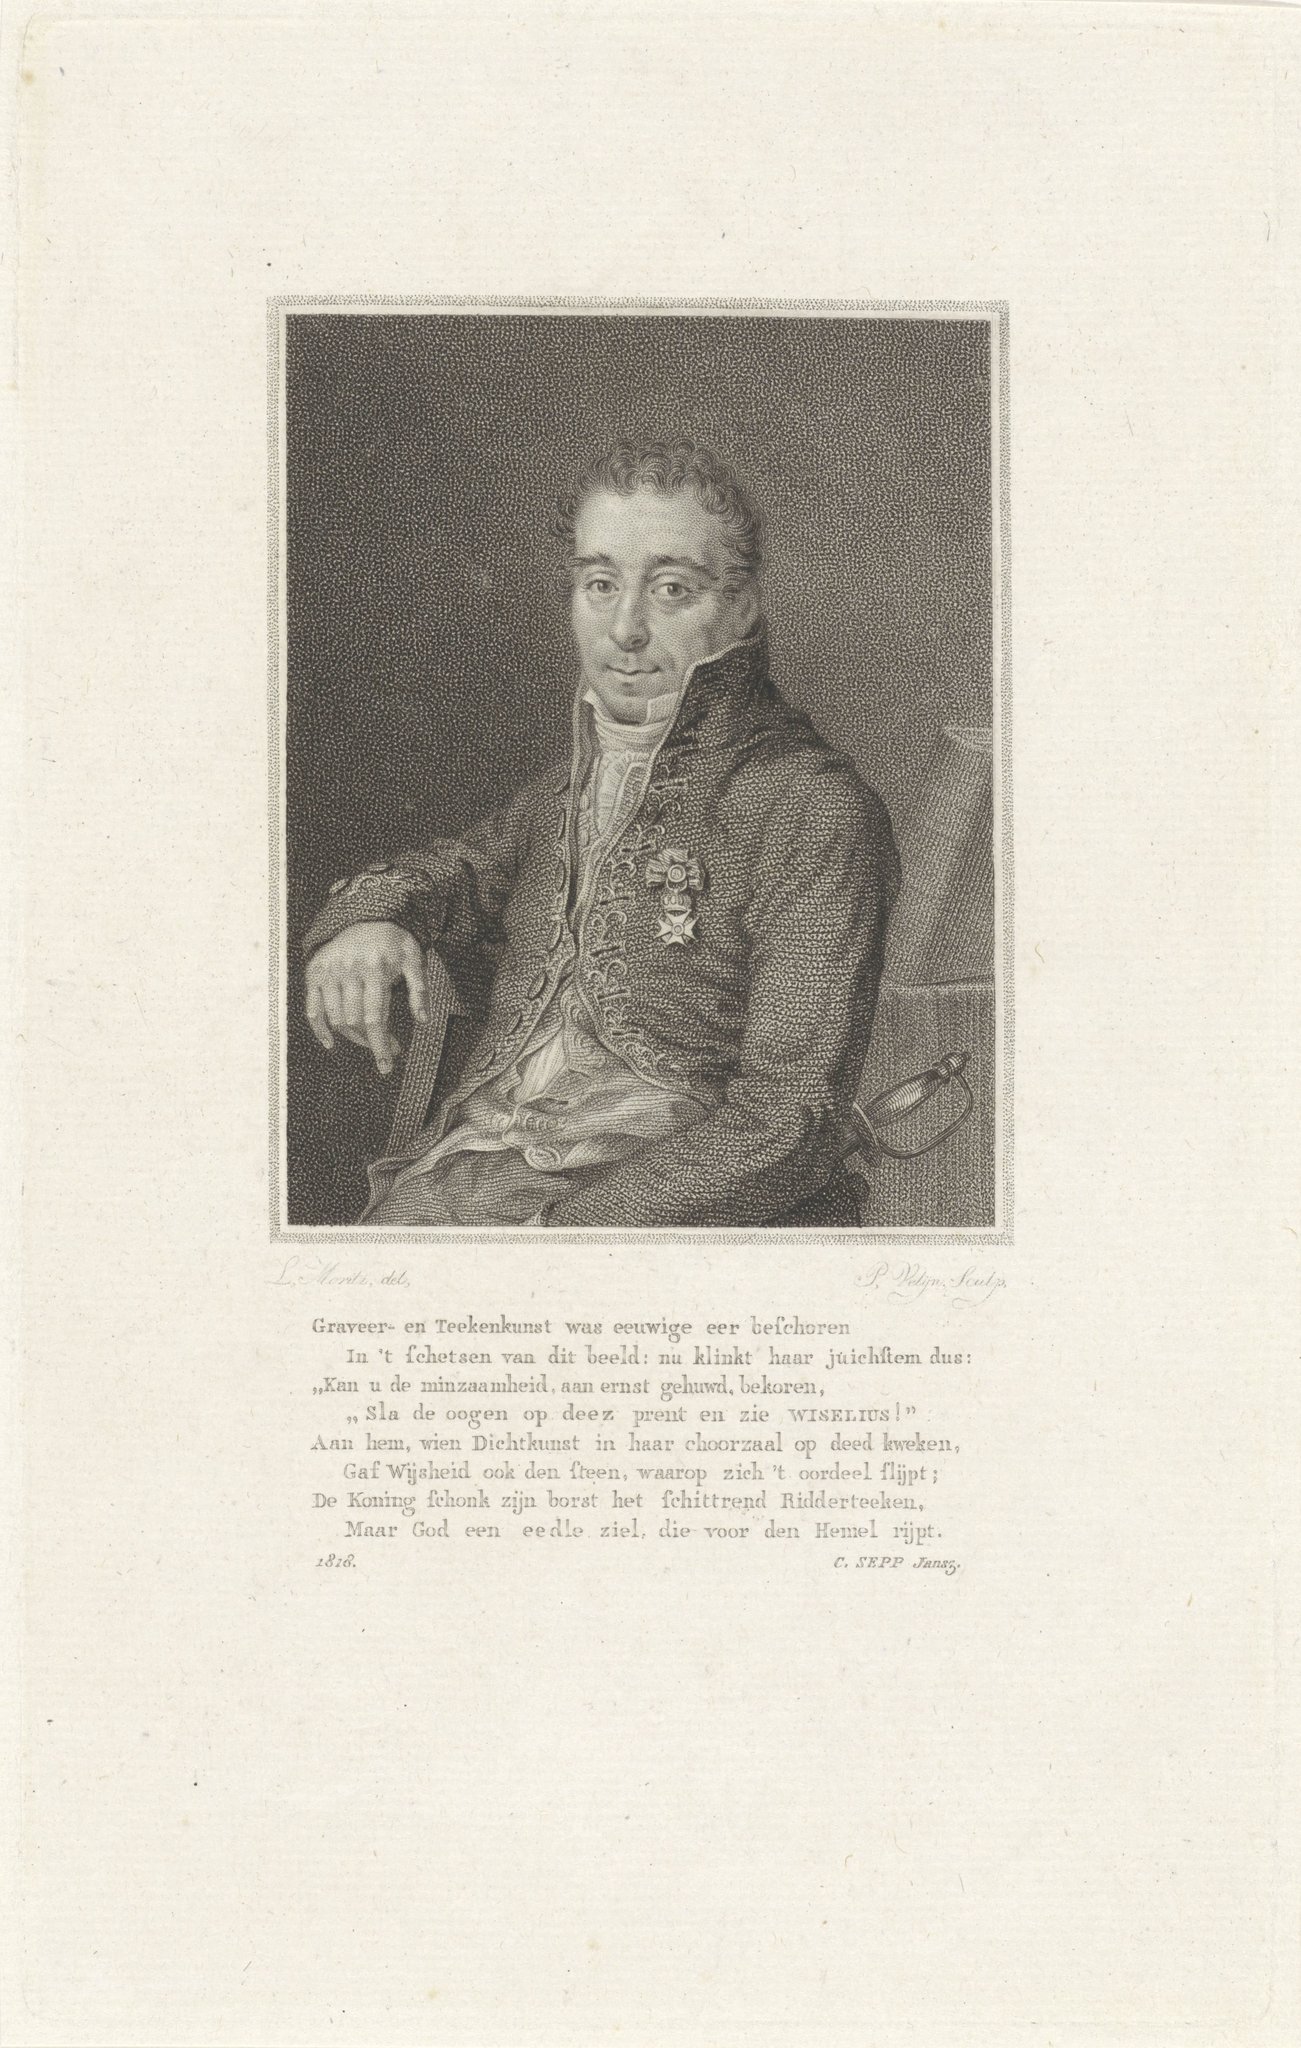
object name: print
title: Portret van Samuel Iperuszoon Wiselius zittend op een stoel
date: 1818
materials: paper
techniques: engraving, etching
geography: netherlands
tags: dichter, samuel iperuszoon wiselius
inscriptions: collector's mark: Lugt 2228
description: Portret van Samuel Iperuszoon Wiselius, bestuurder, dichter en toneelschrijver te Amsterdam, zittend op een stoel met zijn rechterarm op de leuning. Op zijn borst een ridderorde.